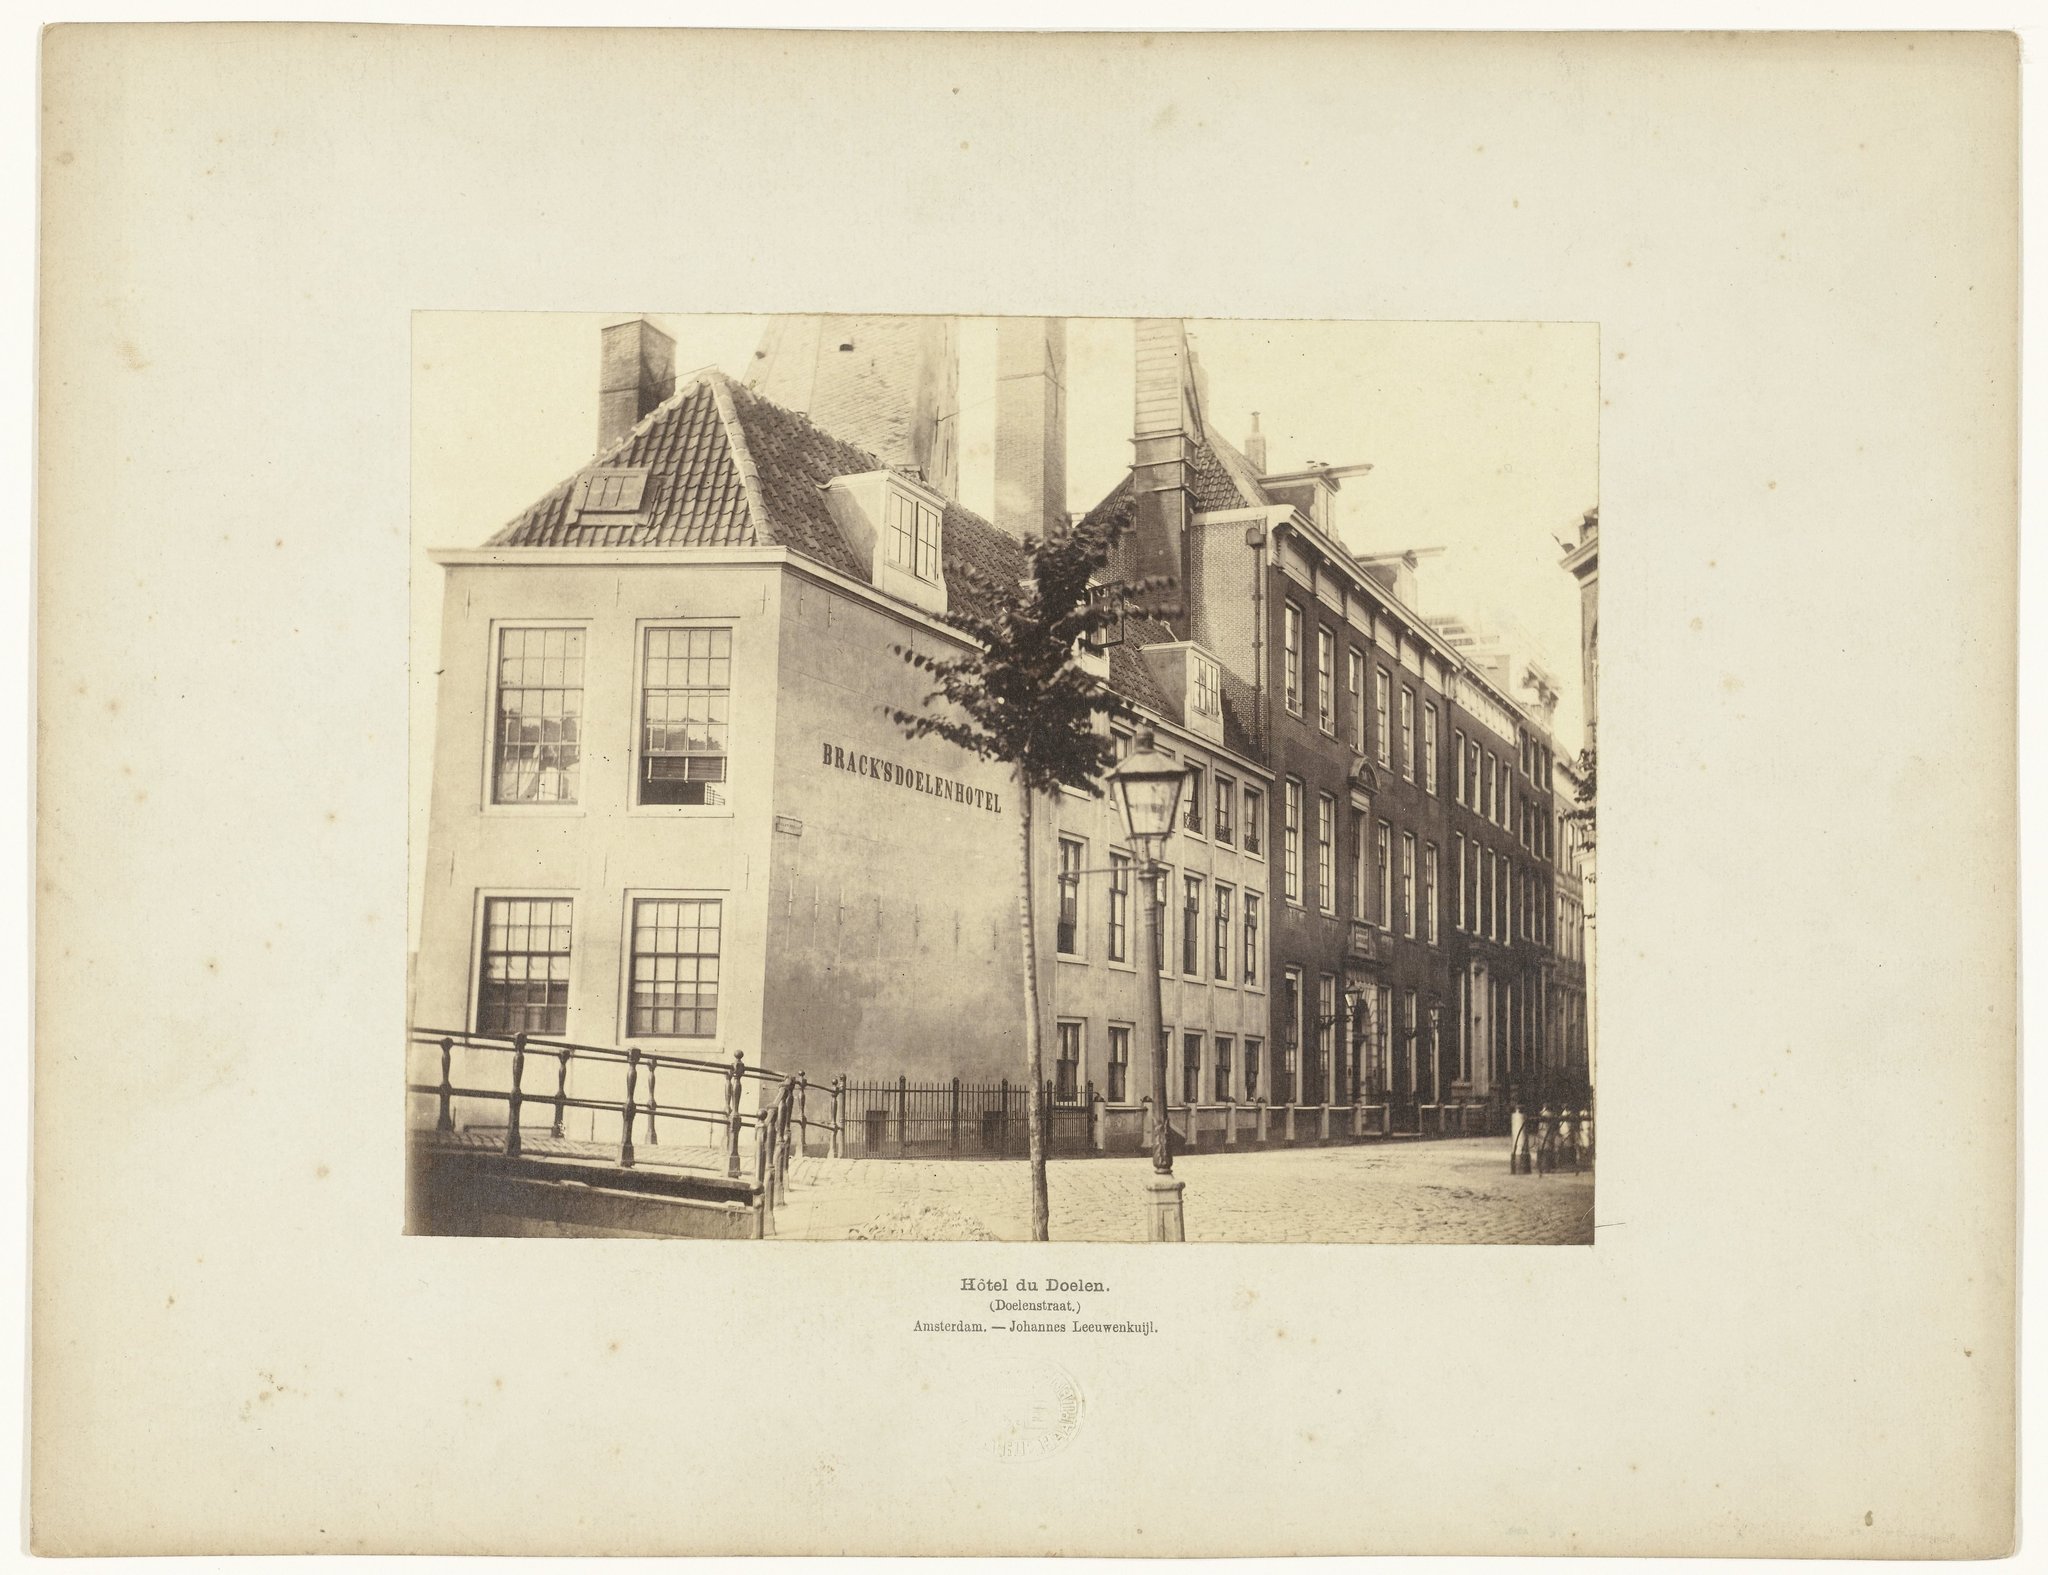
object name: photograph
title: Doelenhotel te Amsterdam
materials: cardboard, paper, photographic support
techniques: albumen print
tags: hotel, hostelry, inn, amsterdam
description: Hôtel du Doelen. / (Doelenstraat.) [...]